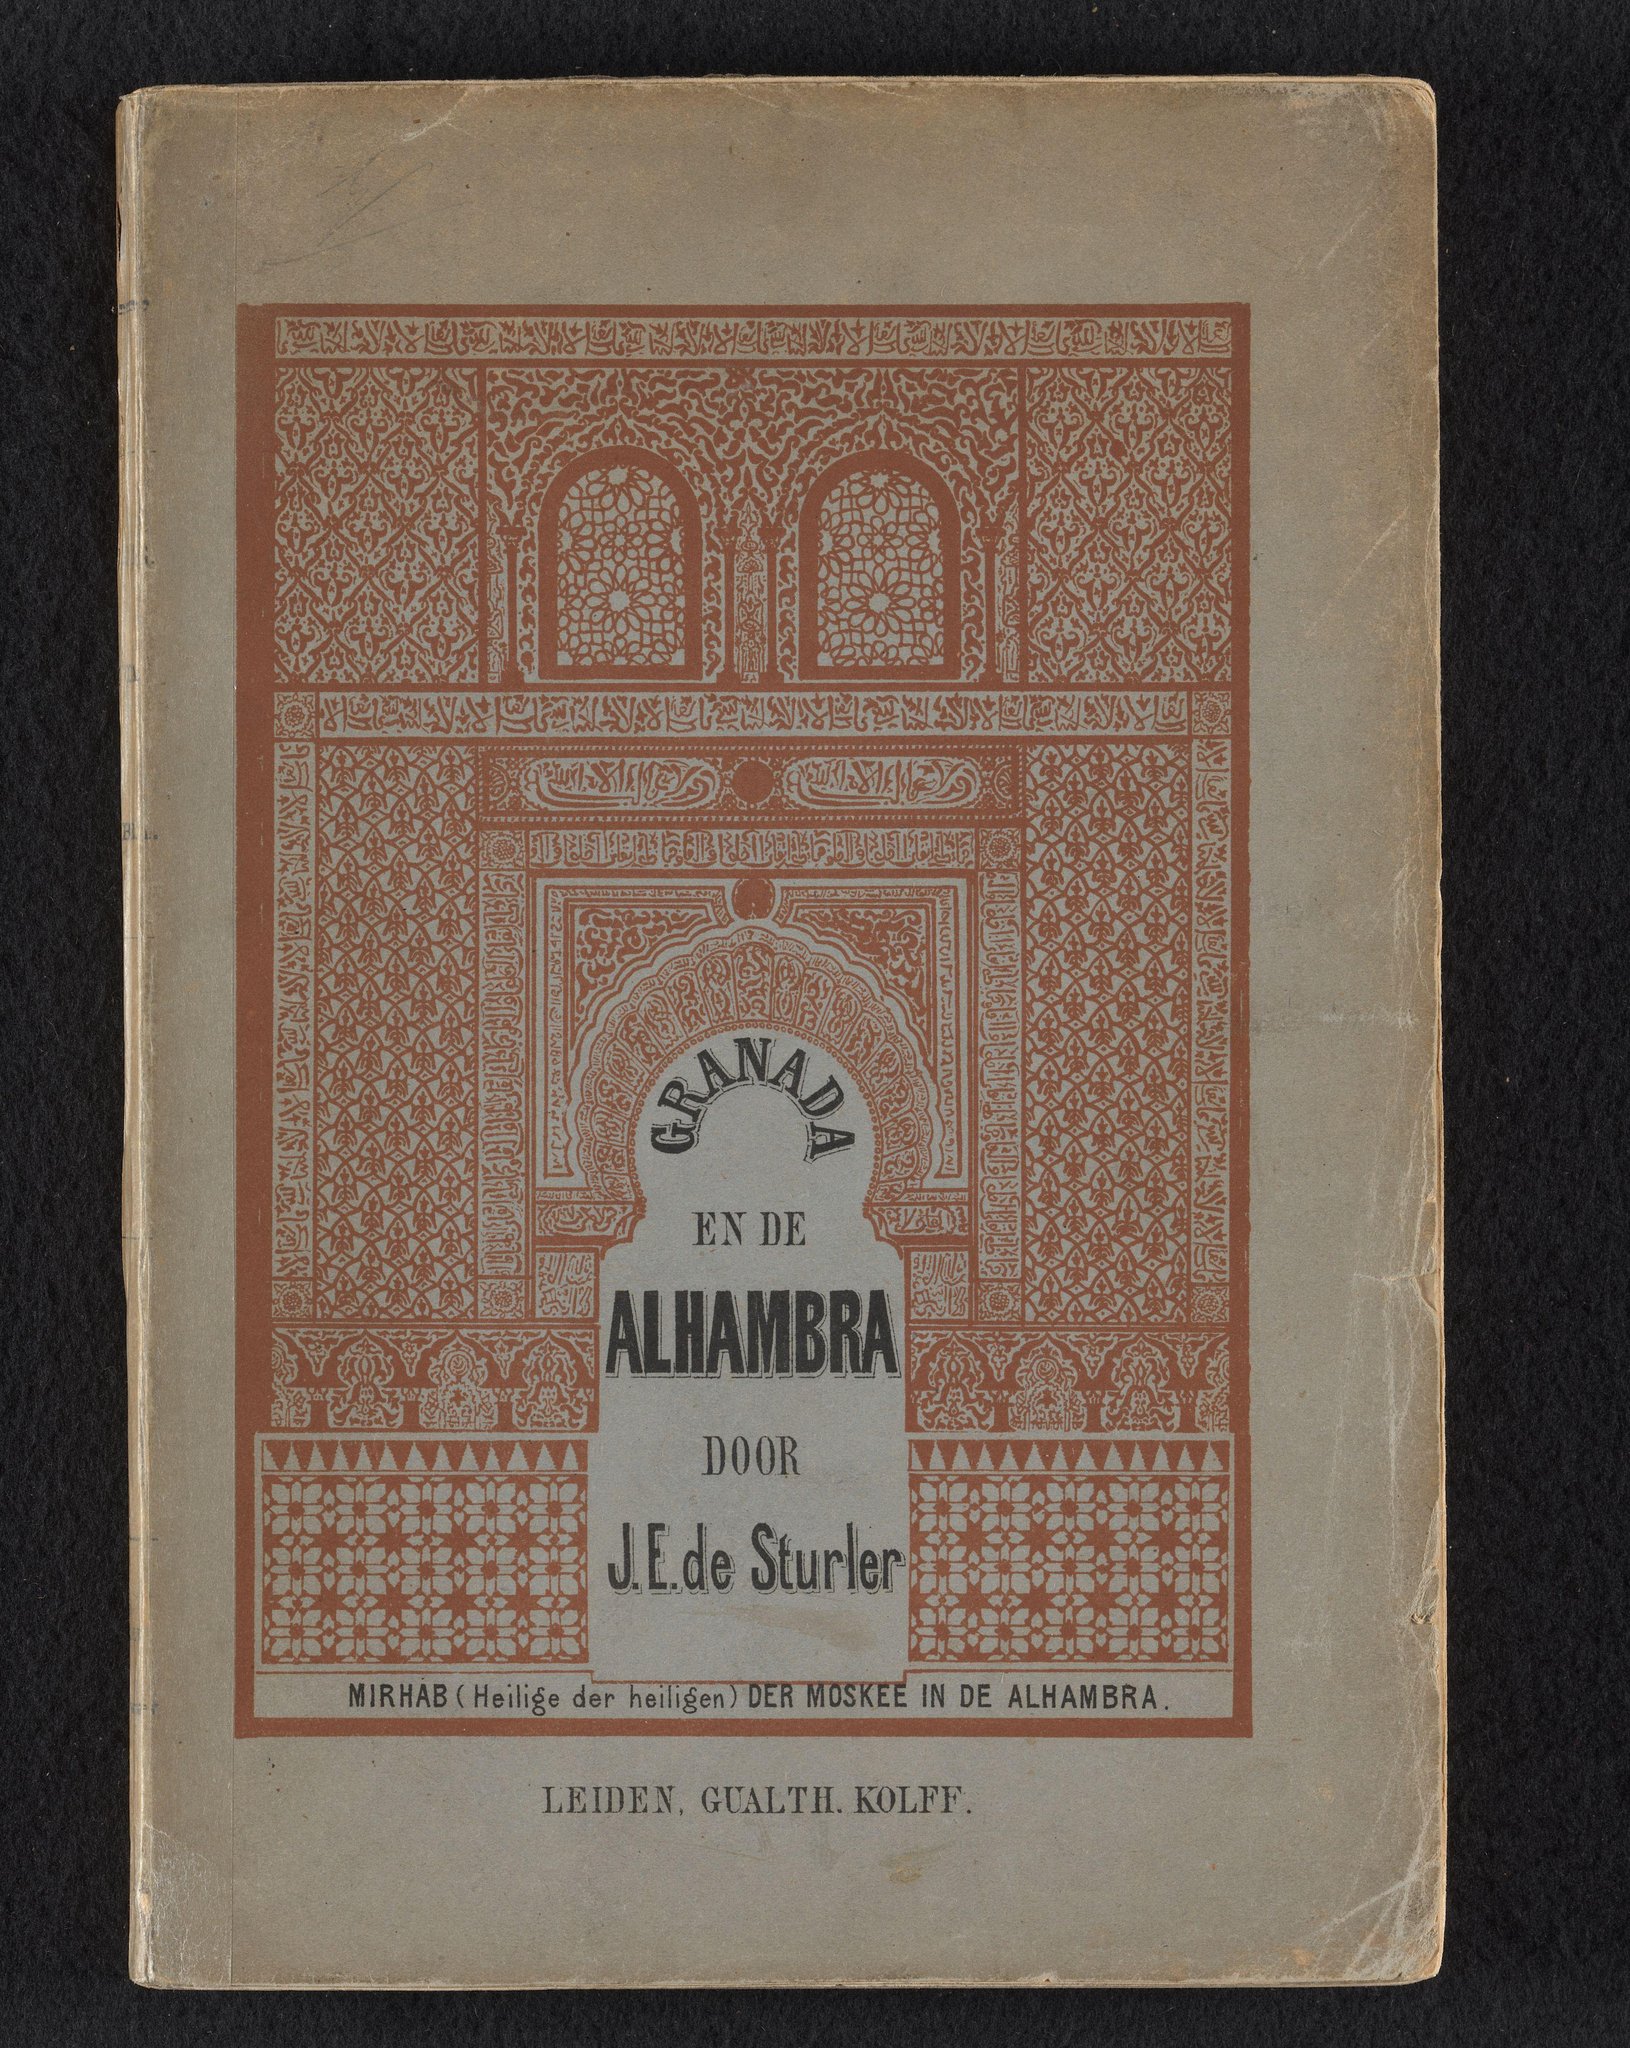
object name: book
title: Granada en de Alhambra : geschiedenis en reisherinneringen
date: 1880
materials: cardboard, paper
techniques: albumen print, letterpress printing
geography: leiden